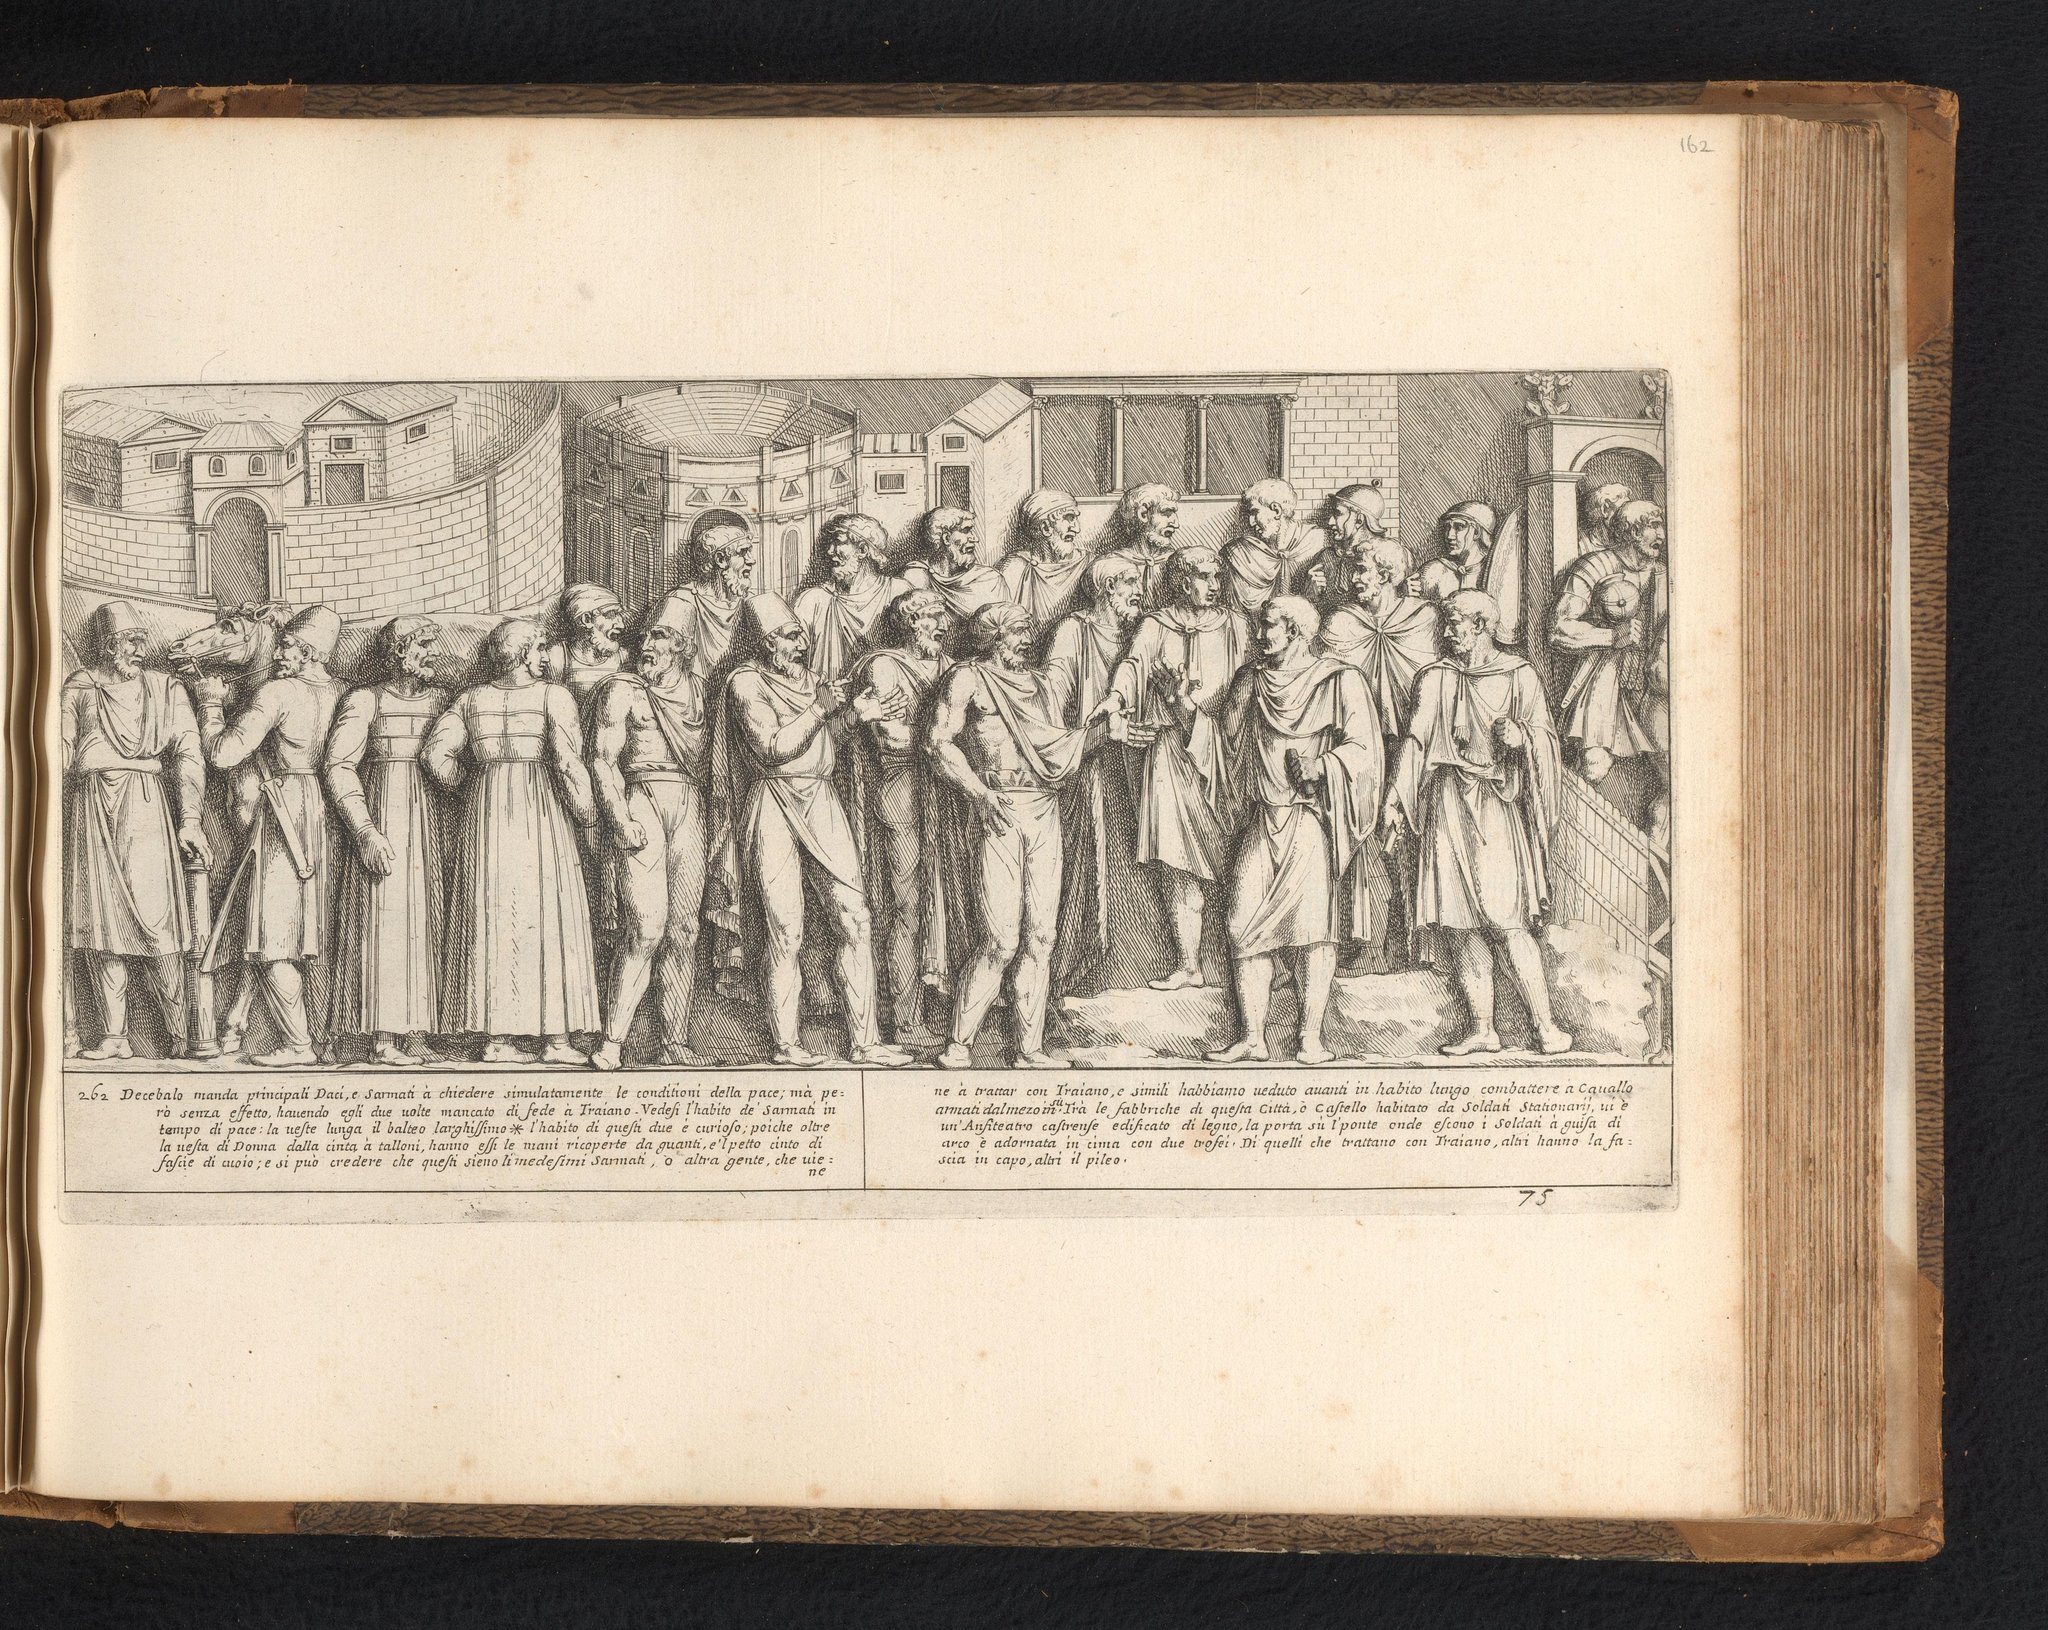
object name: print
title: Colonna Traiana eretta dal senato, e popolo Romano all' imperatore Traiano Augusto nel suo foro in Rom (...)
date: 1637-1691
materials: paper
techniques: etching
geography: rome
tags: triumphal column with helical friezes, piece of sculpture, reproduction of a piece of sculpture, the soldier; the soldier's life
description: Detail van het spiraalvormige gebeeldhouwde fries op de Zuil van Trajanus. Het fries toont de oorlogen tussen de Romeinen en de Daciërs. Verklarende nummers in de ondermarge. Prent maakt deel uit van een album.